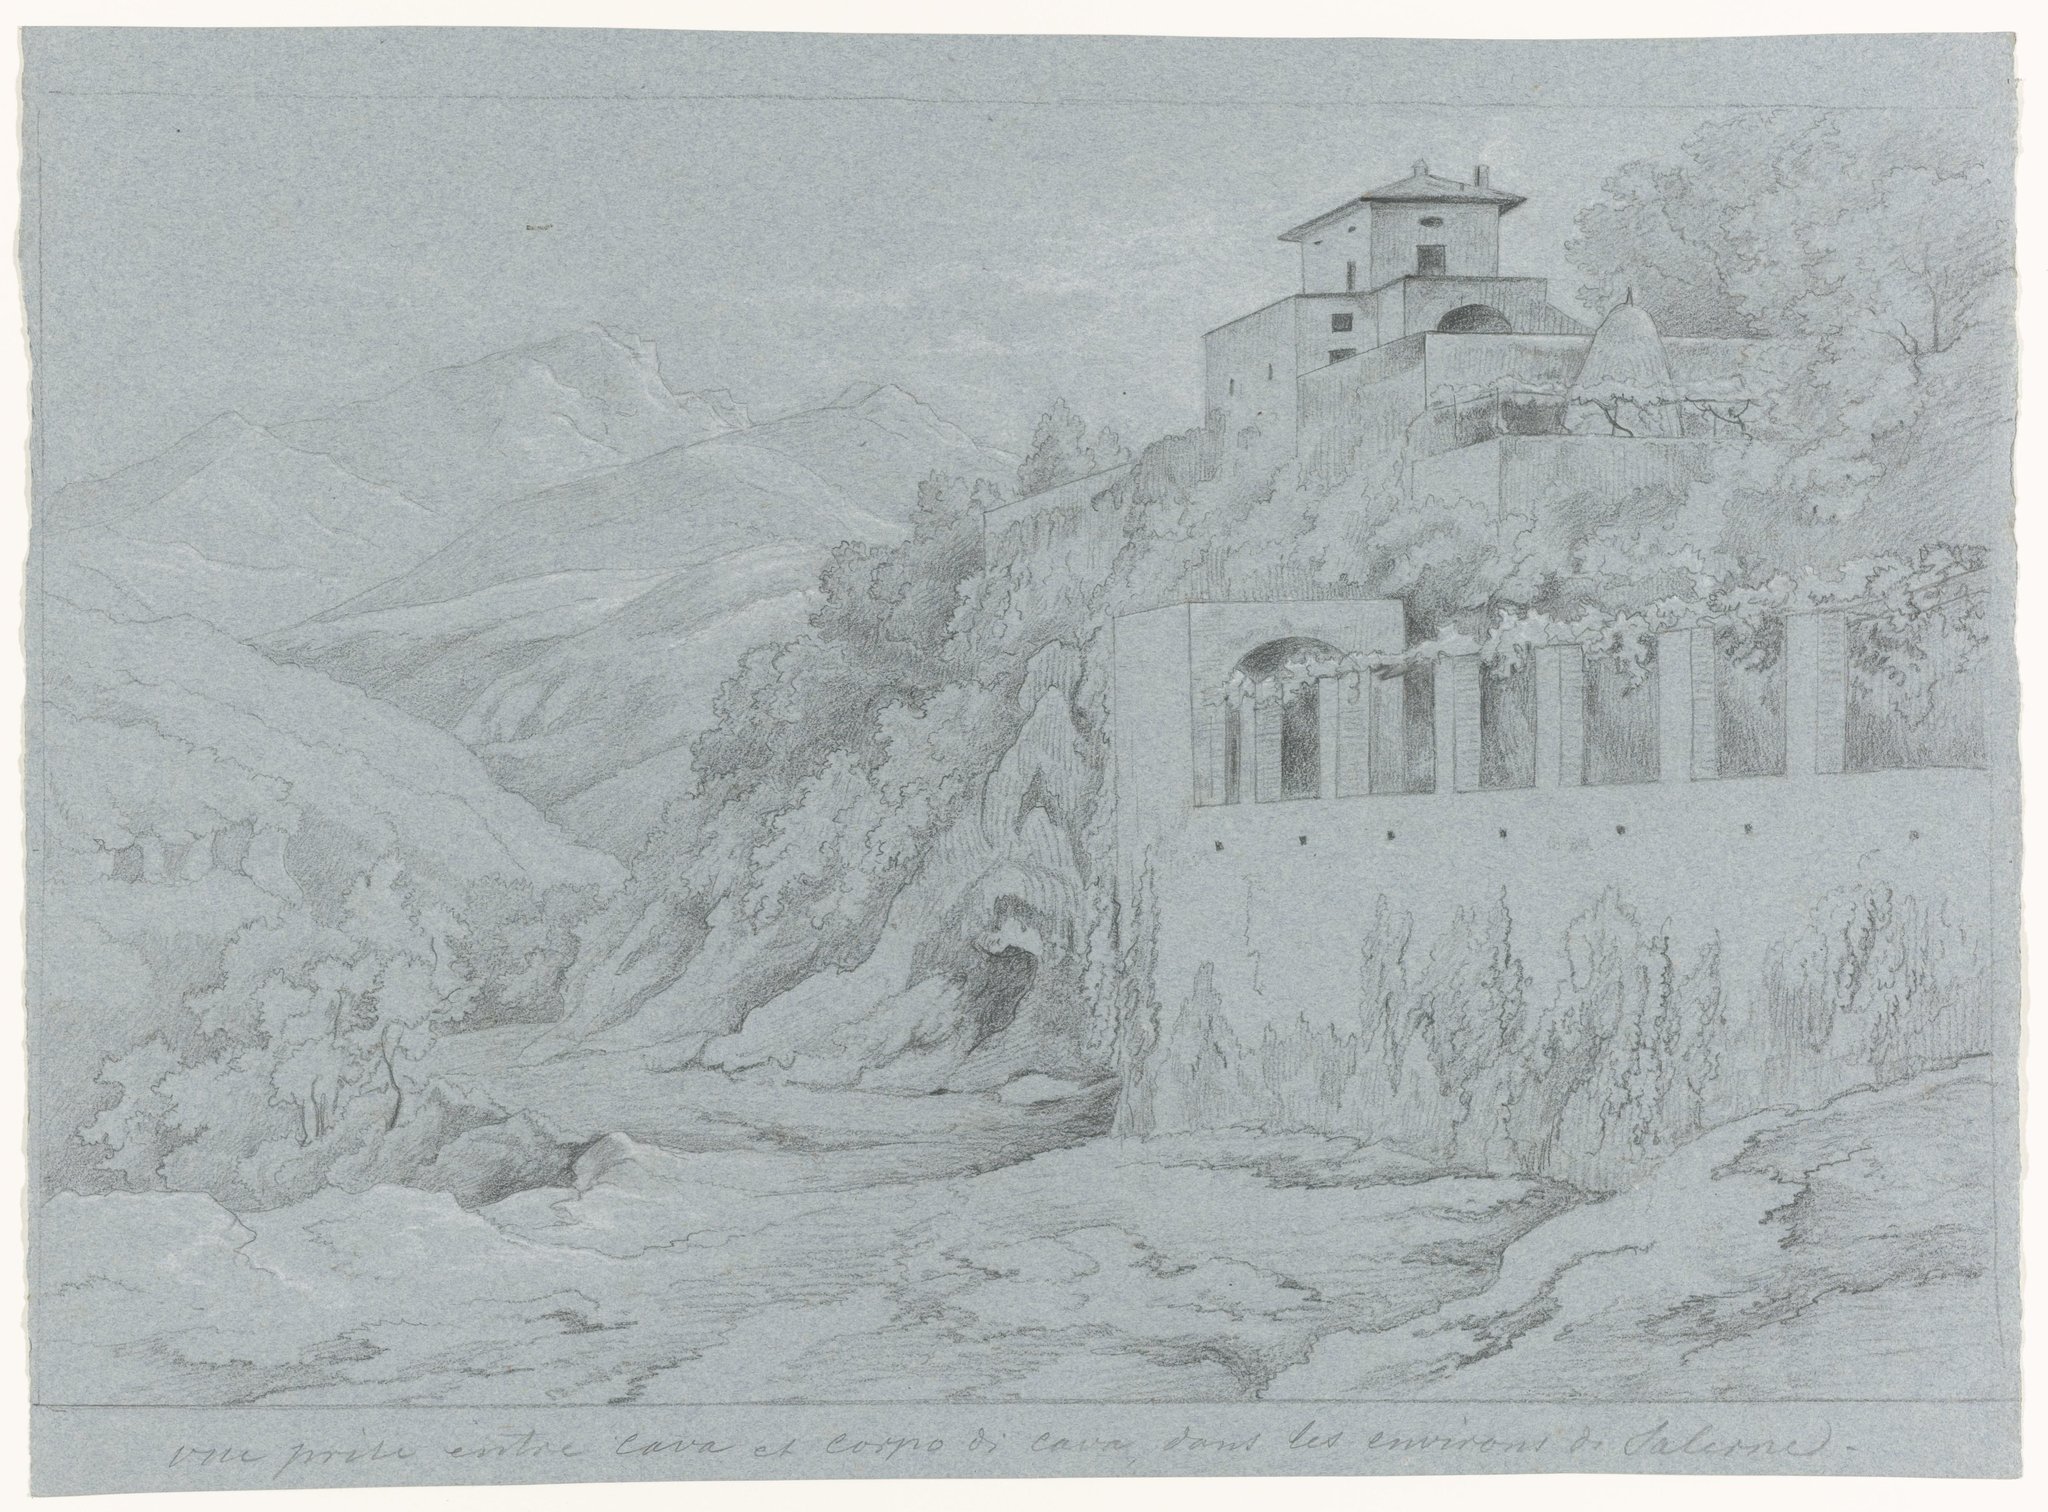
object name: drawing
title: Gezicht bij Salerno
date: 1786-1857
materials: chalk, paint, paper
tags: landscapes in the temperate zone, villa, salerno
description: Tekening uit een groep tekeningen van landschappen en stadsgezichten in Italië (Rome, Tivoli, Civita Castellana en Pozzuoli).